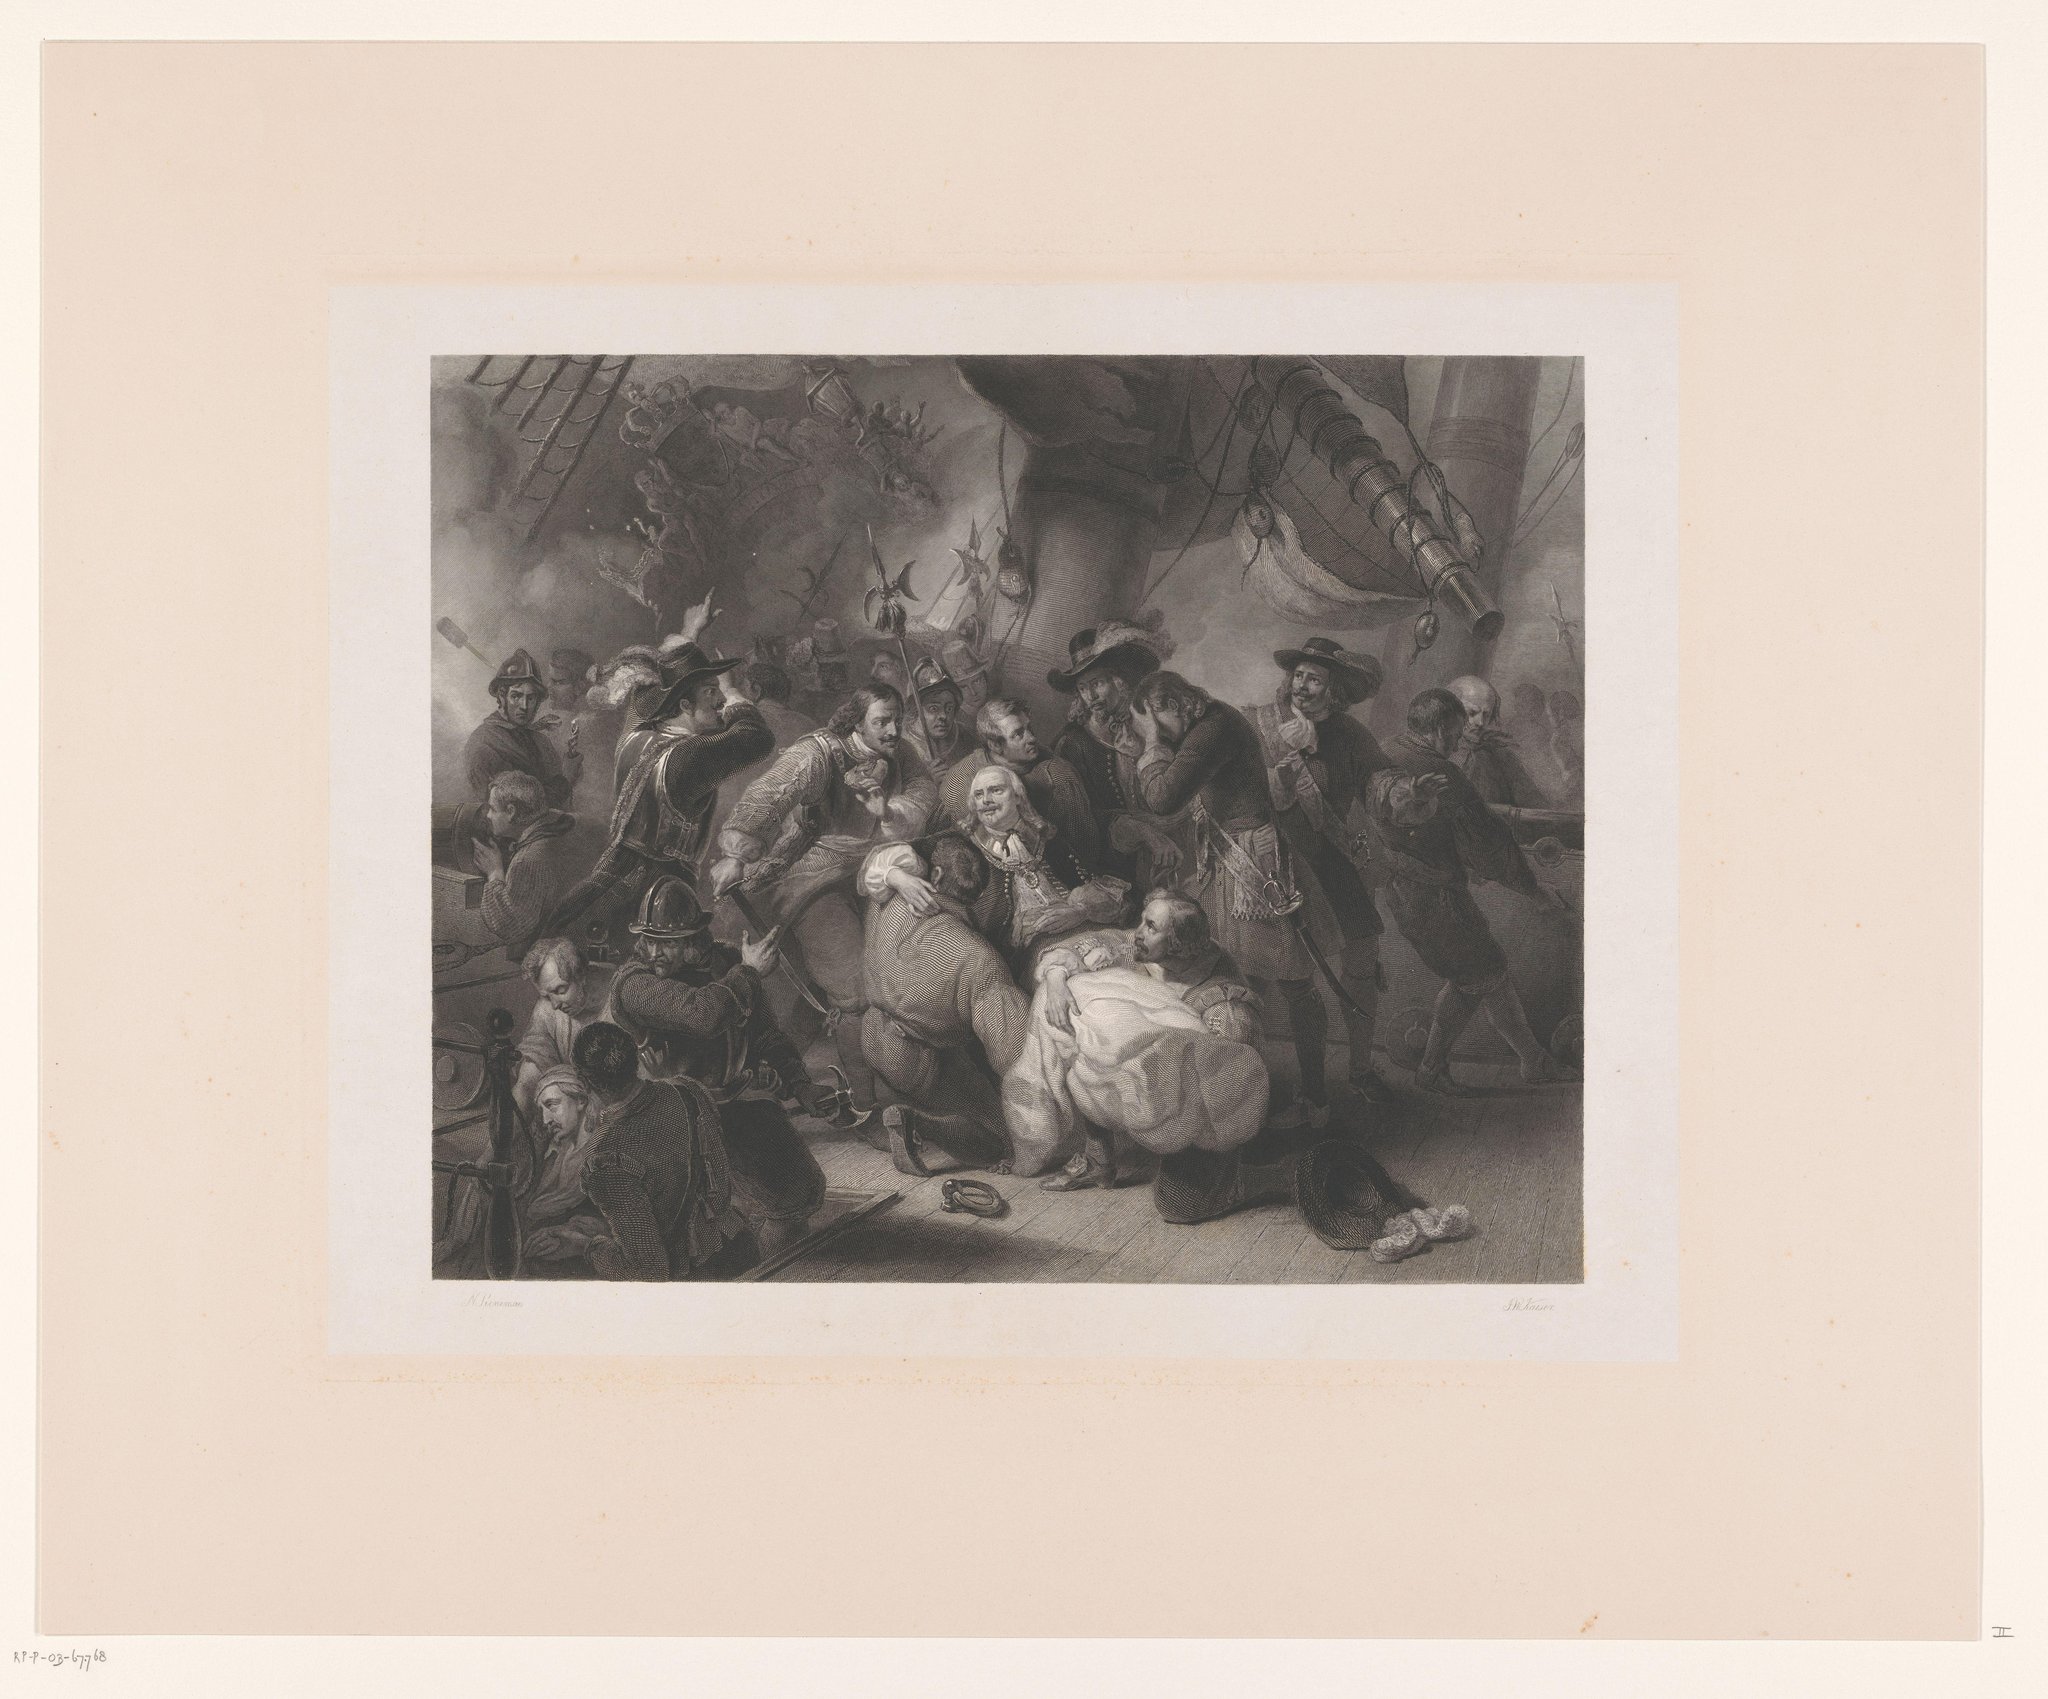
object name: print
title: La Défense de Paris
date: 1883-1889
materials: paper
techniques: engraving, etching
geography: paris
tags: hacking and thrusting weapons: sword, monument, statue, paris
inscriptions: collector's mark: Lugt 2228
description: Prent naar een monument voor de verdediging van Parijs tijdens de Frans-Duitse Oorlog. Het monument staat op een rotonde in Courbevoie en werd in 1883 onthuld.